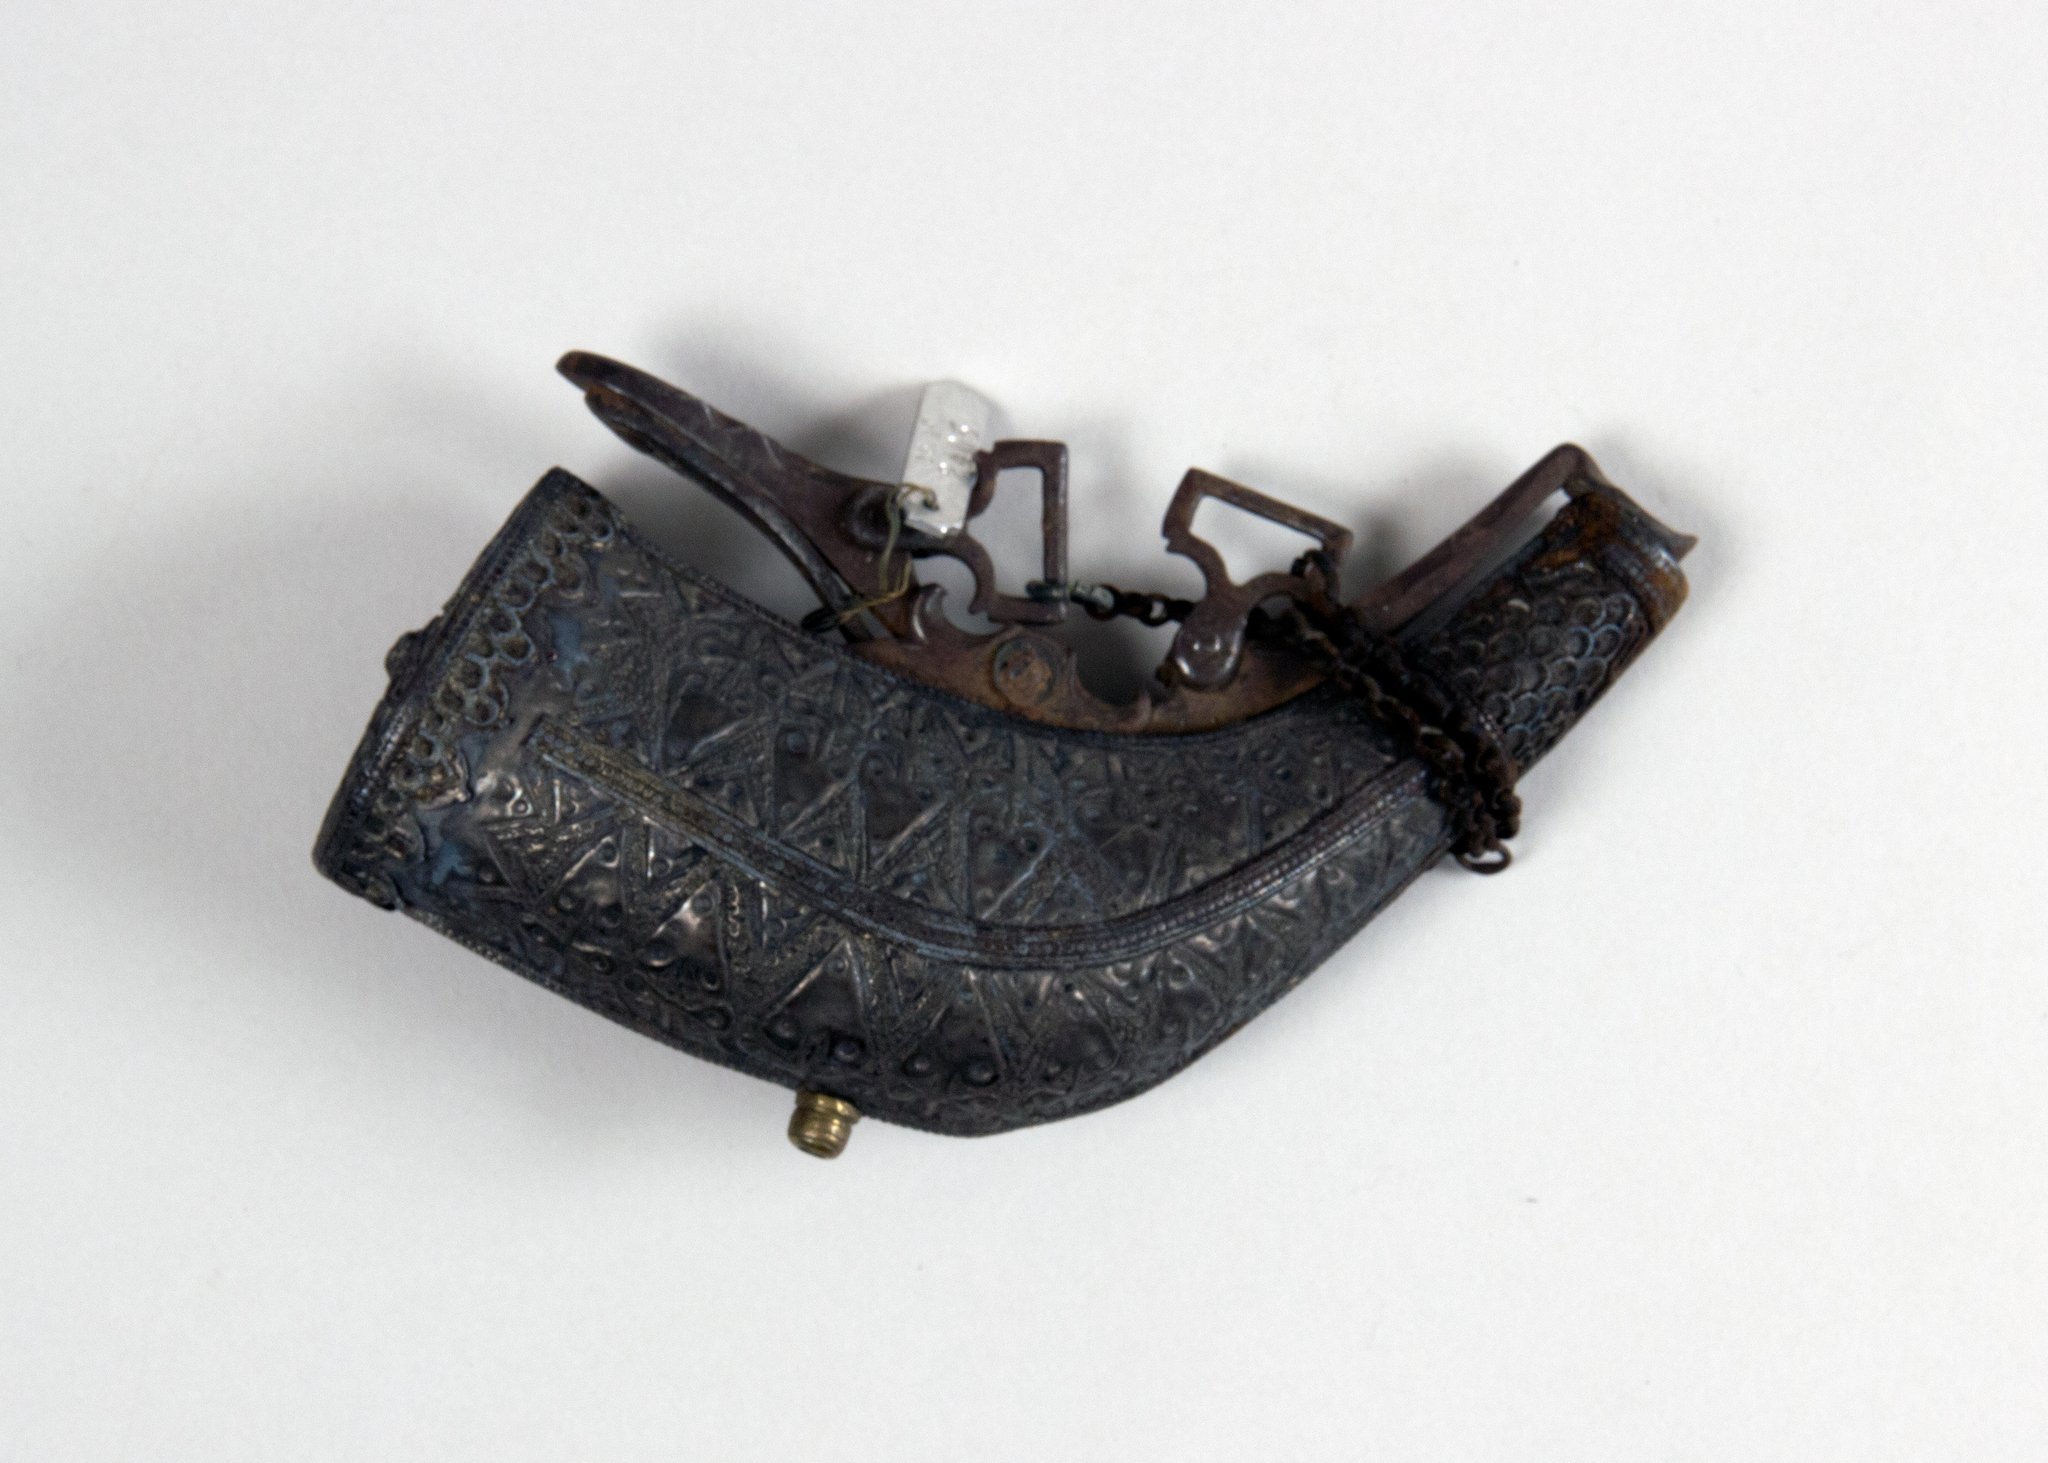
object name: primer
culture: greek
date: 1701-1800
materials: copper alloy, silver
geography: greece